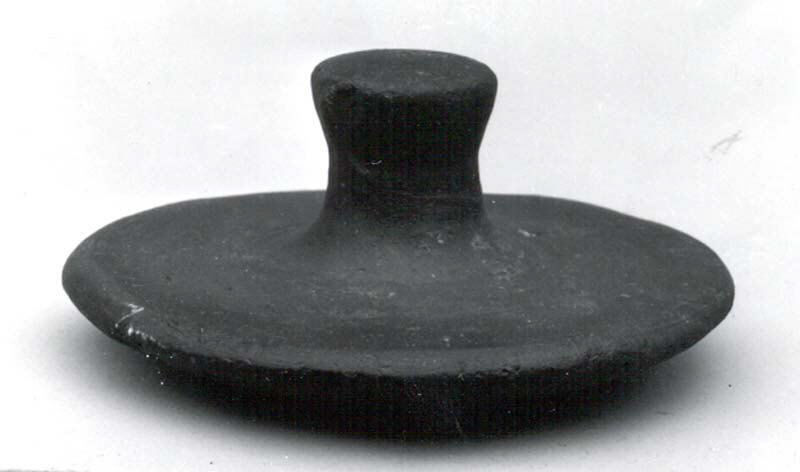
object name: vessel with lid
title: Vessel lid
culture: sasanian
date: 201-700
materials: ceramic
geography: iran